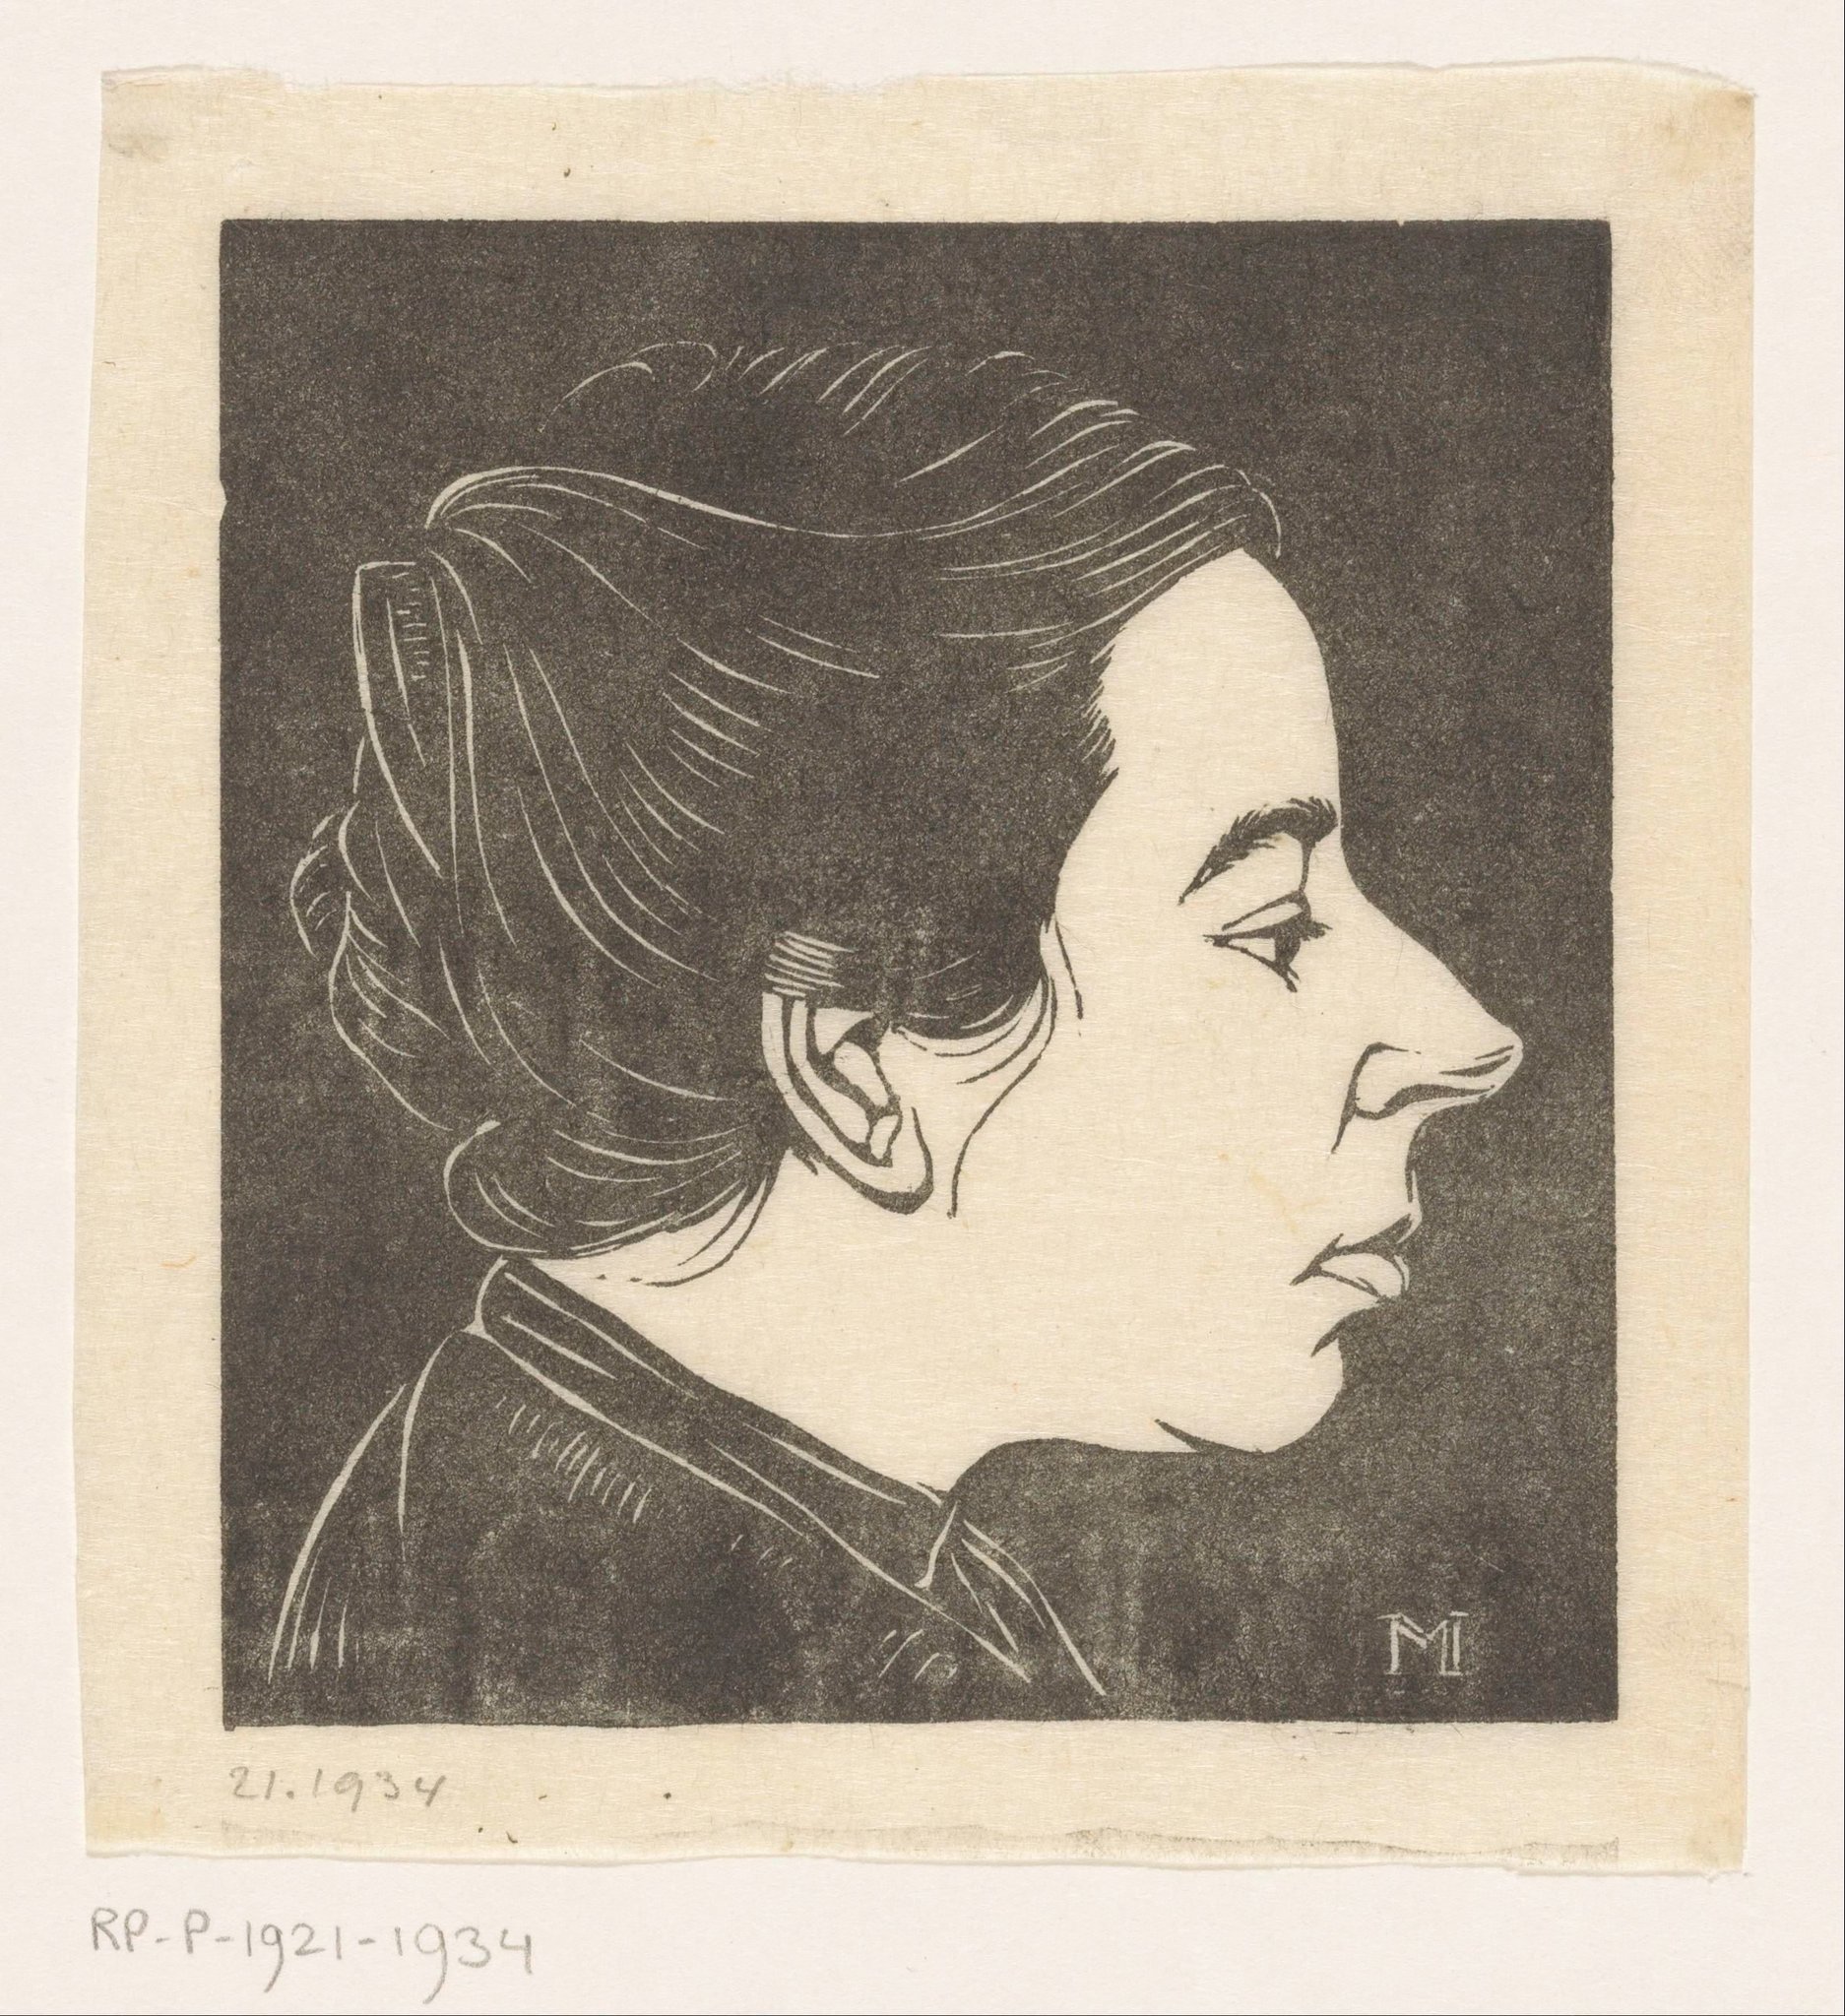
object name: print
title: Portret van Anne Zernike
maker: jan mankes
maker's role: draughtsman, painter, print maker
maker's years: 1889-1920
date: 1915-1916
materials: paper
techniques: woodcut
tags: amsterdam, anne mankes-zernike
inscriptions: collector's mark: Lugt 2228